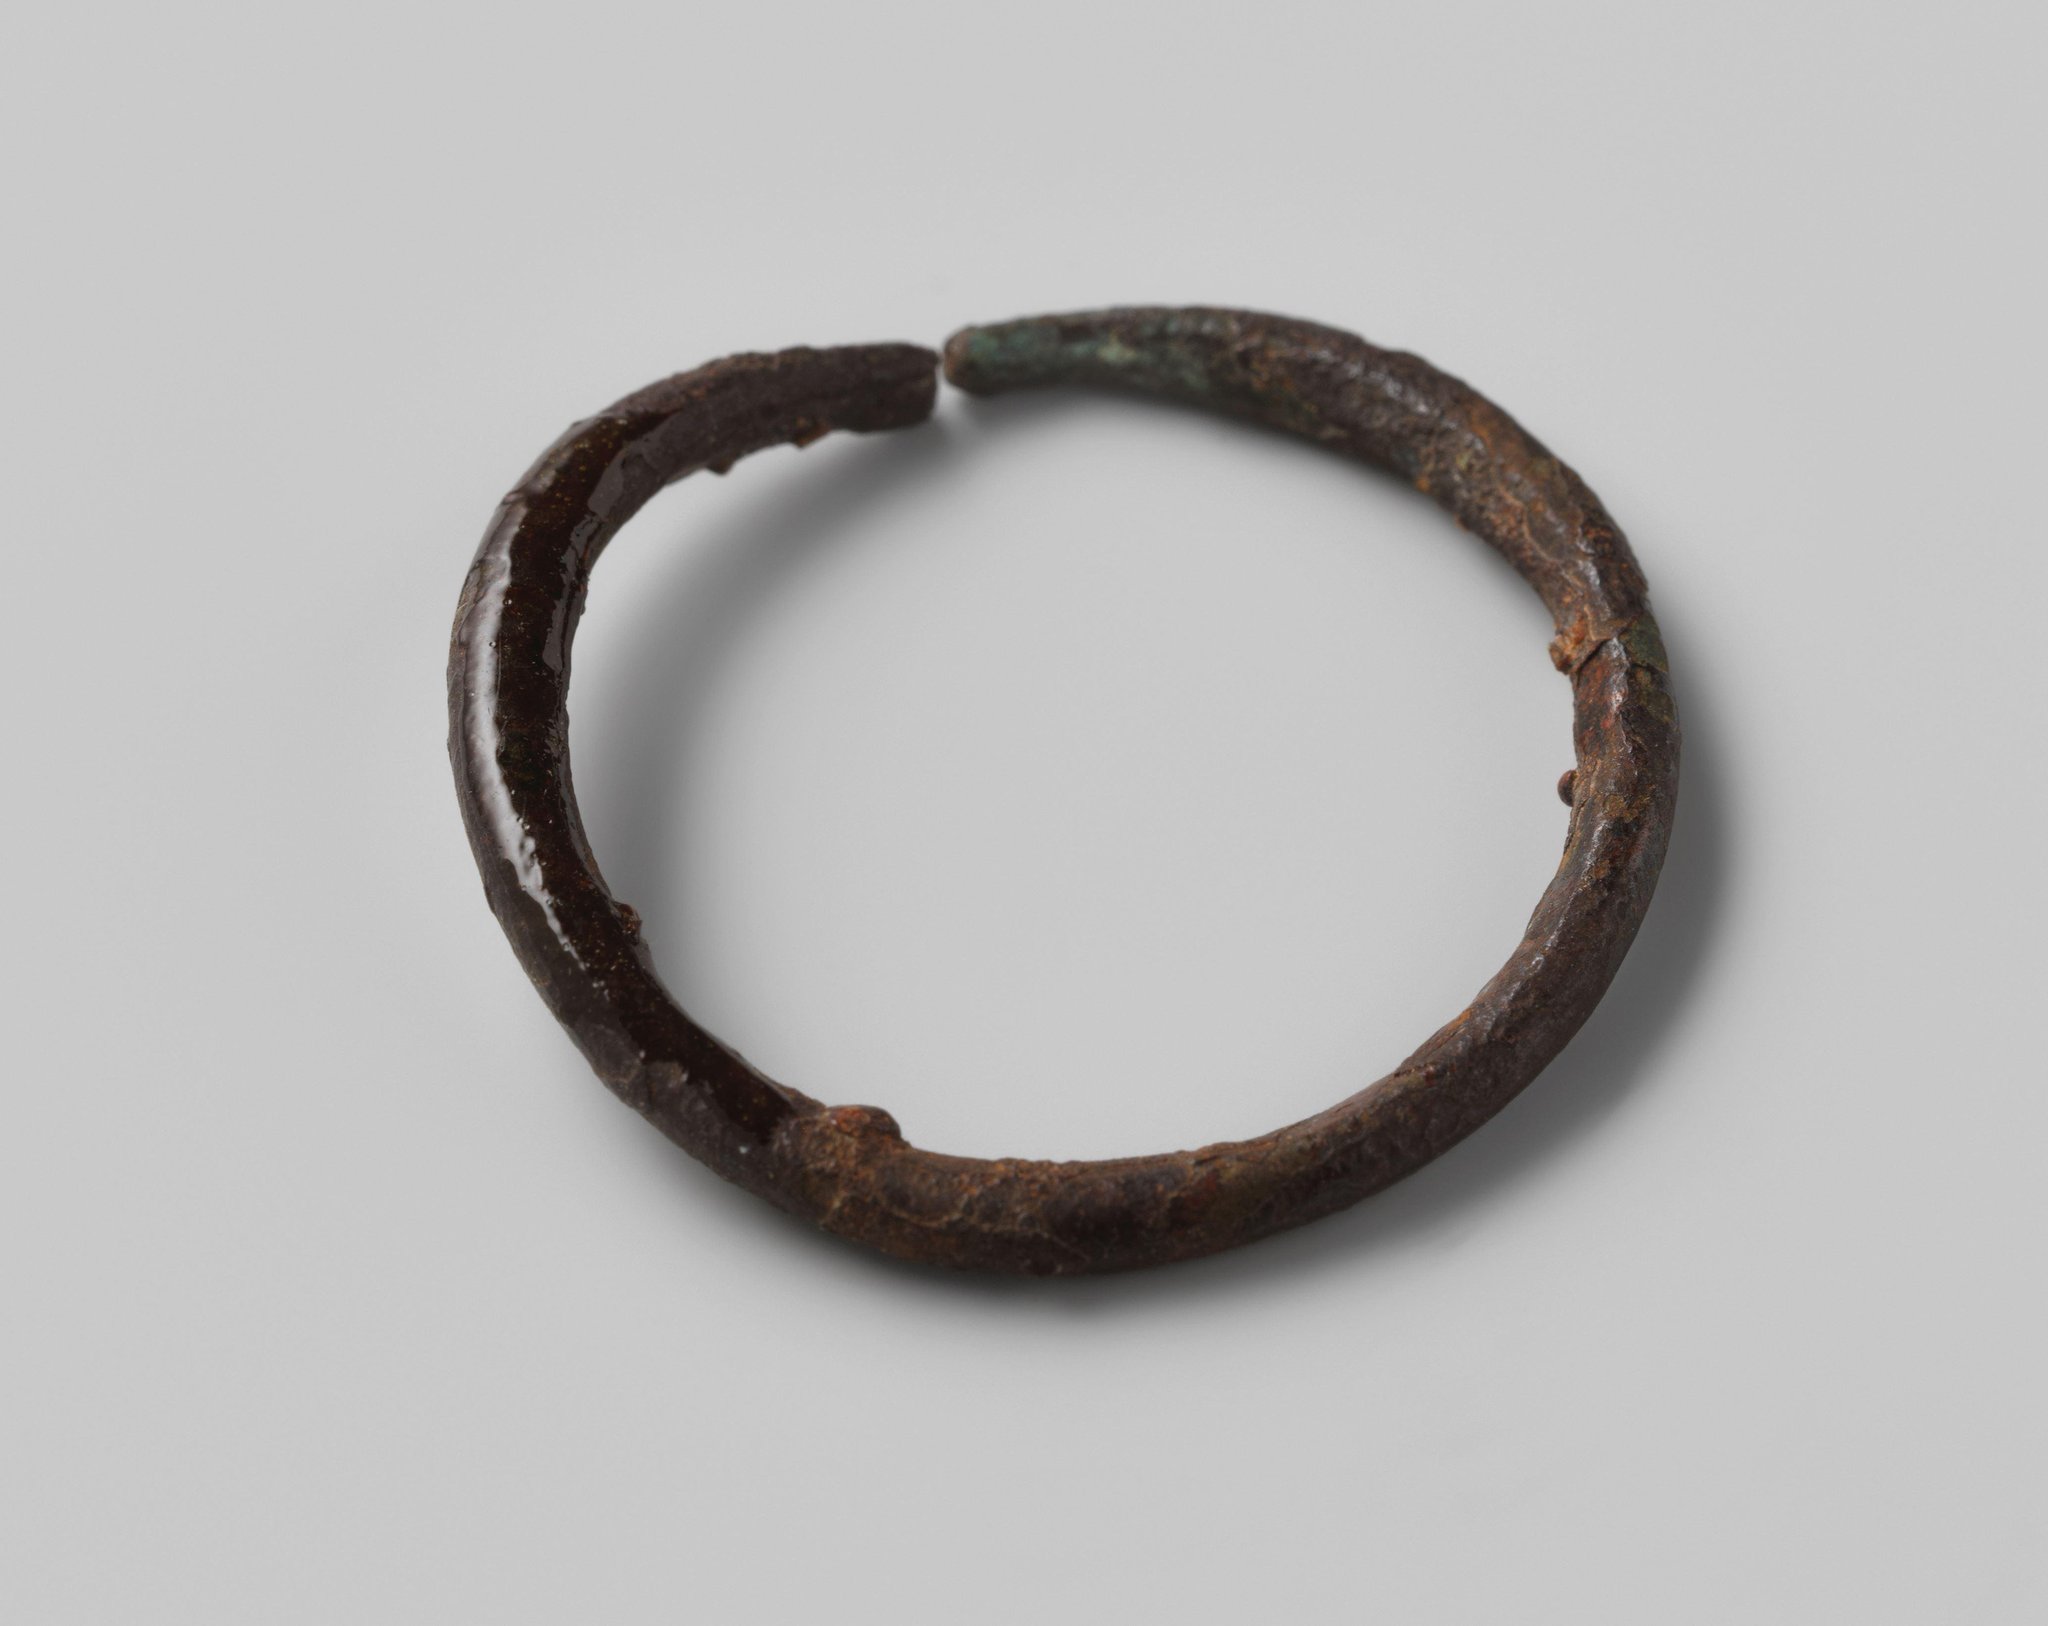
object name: fragment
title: Ringvormig fragment uit het wrak van de Oost-Indiëvaarder Hollandia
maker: Anonymous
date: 1700-1743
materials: copper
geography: netherlands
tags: verenigde oostindische compagnie, hollandia (schip), annet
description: Varied parts or fragments, rings or ring-shaped fragments; eroded, id. 80H946.